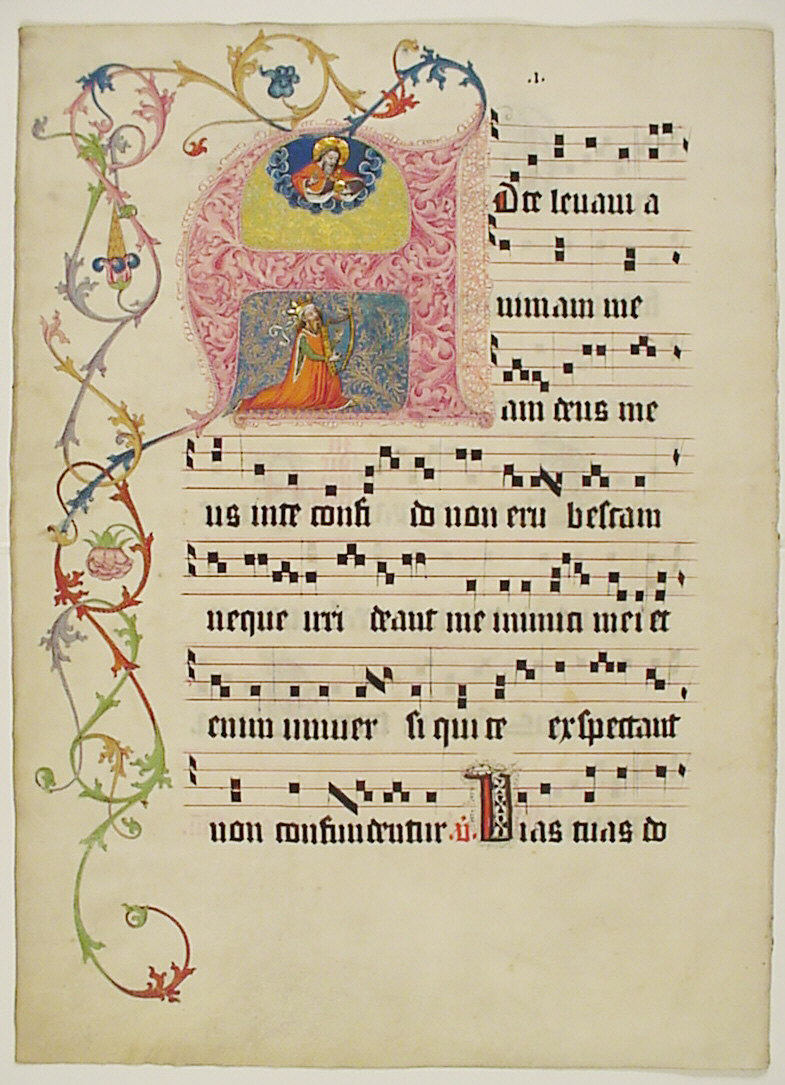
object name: gradual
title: Manuscript Leaf with Initial A, from a Gradual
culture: german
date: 1426-1450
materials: ink, metal leaf, parchment, paint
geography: germany